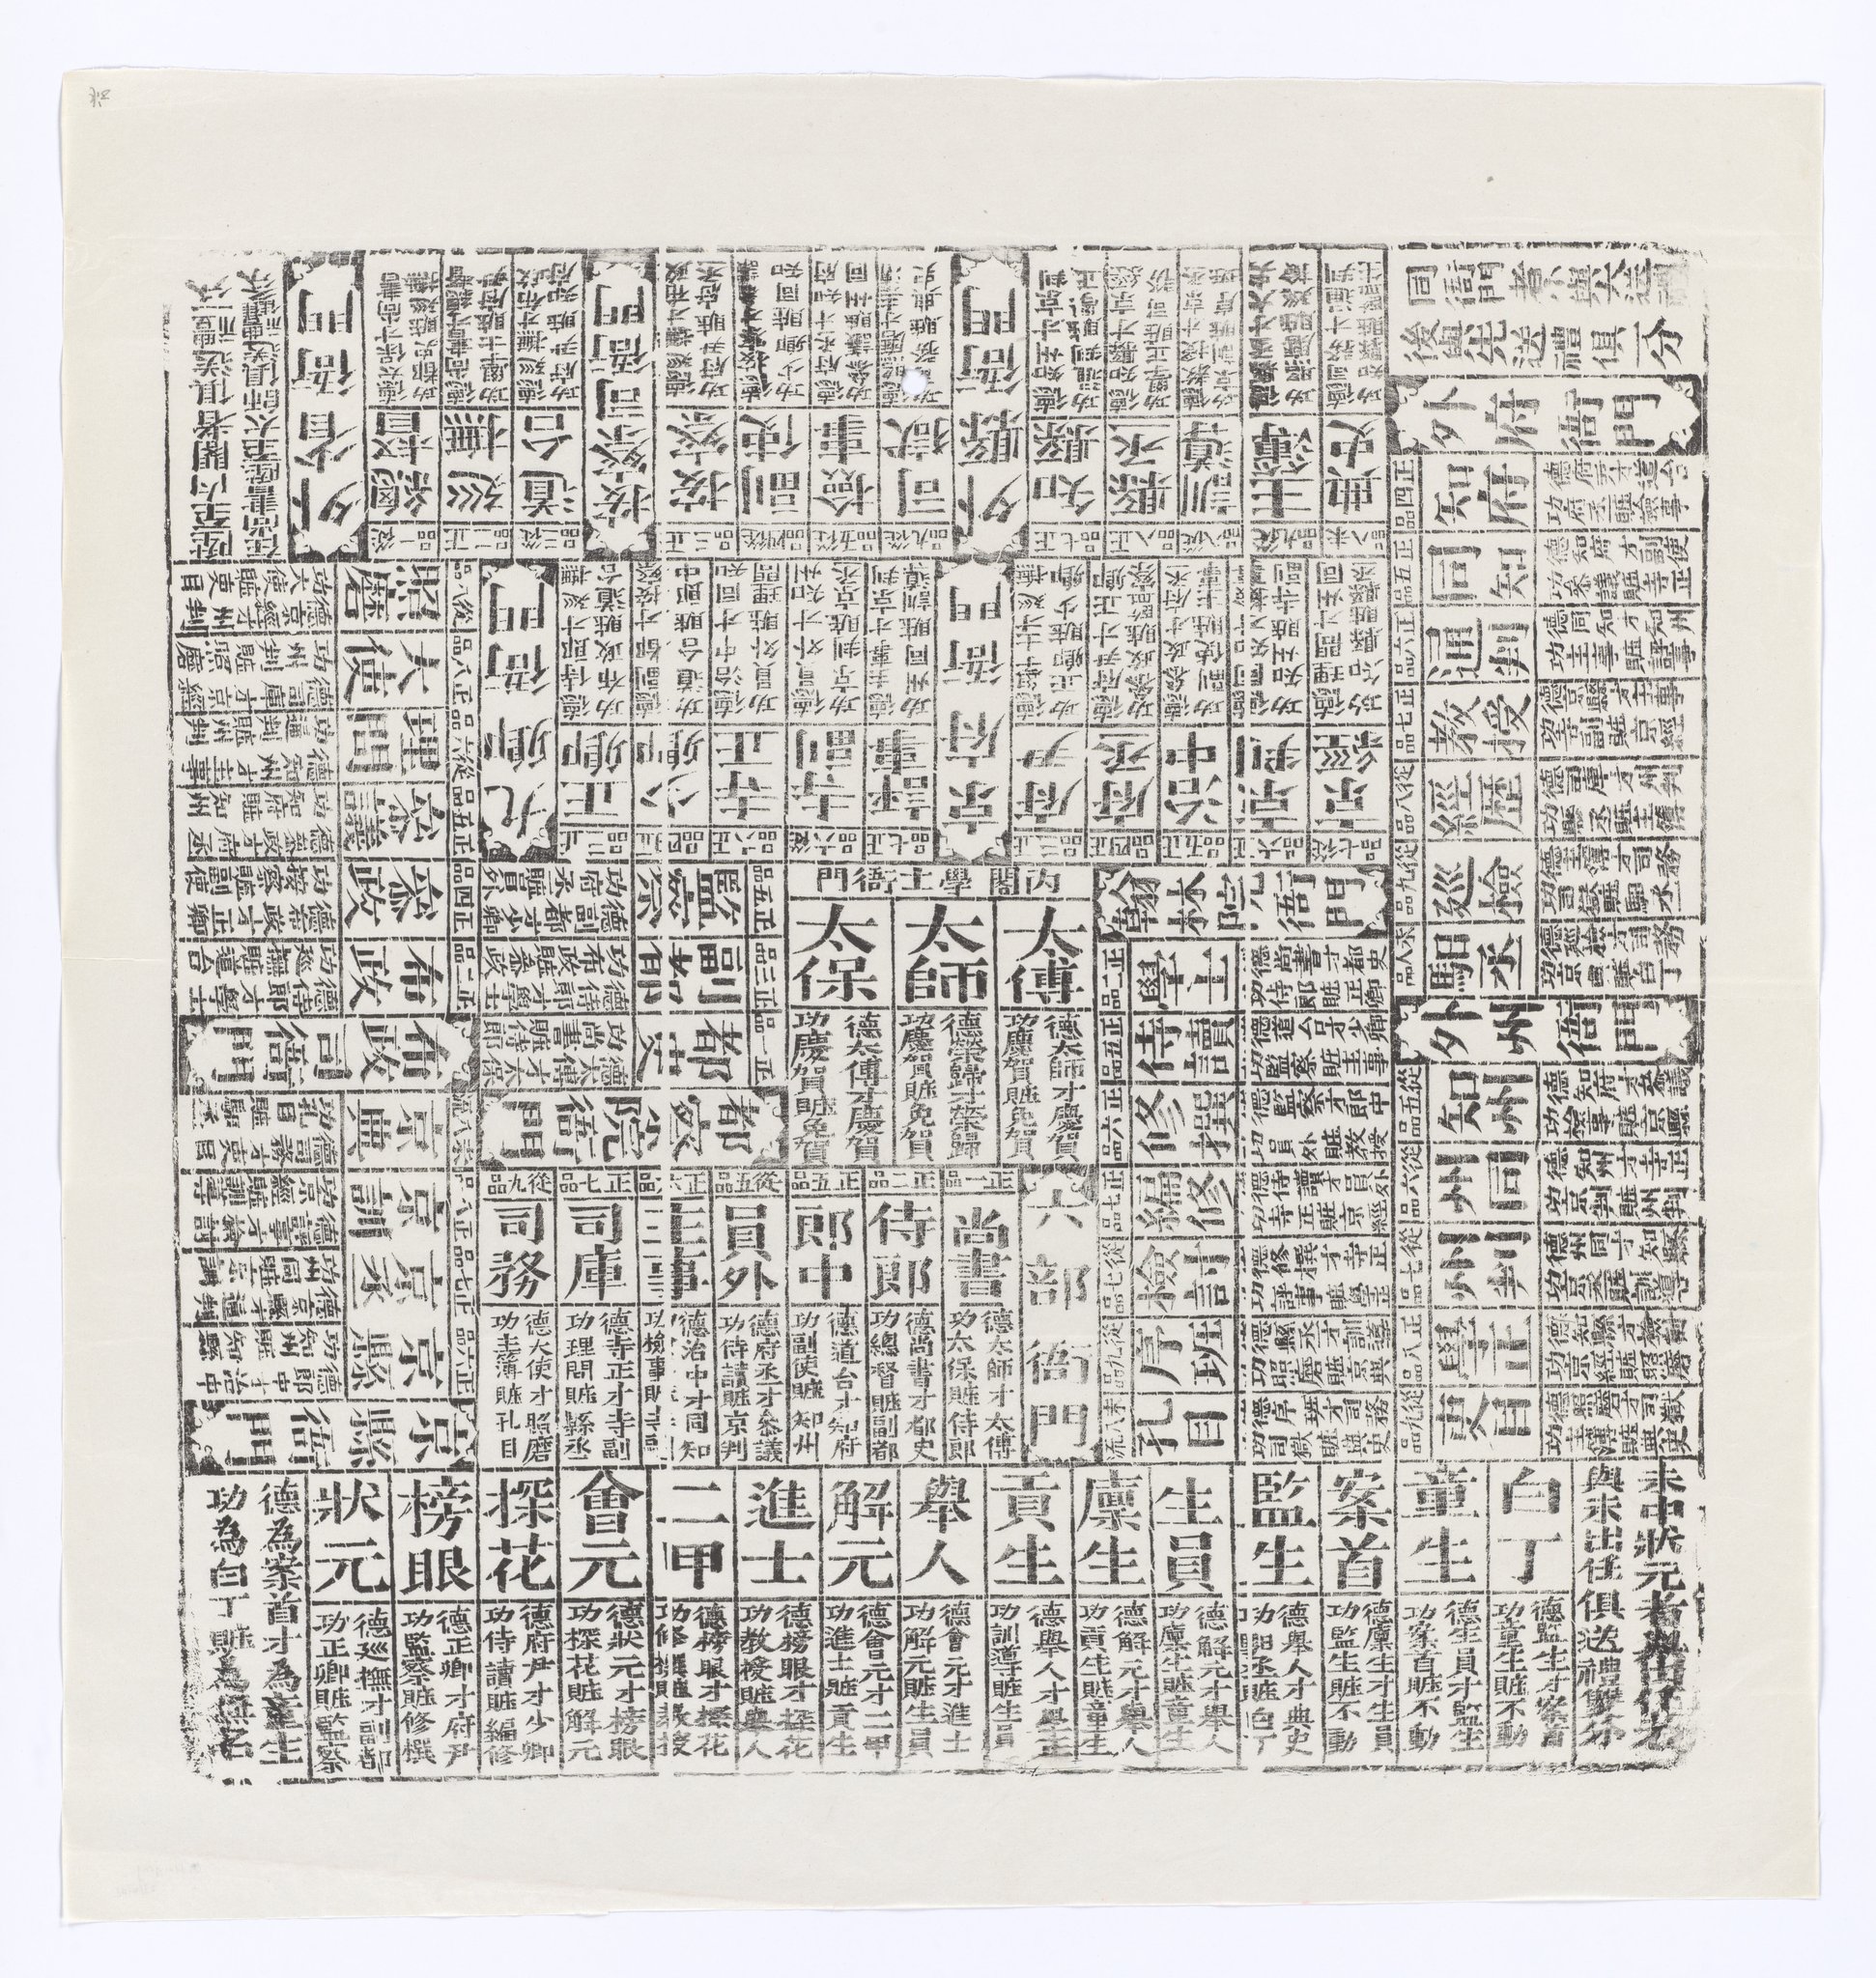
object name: print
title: Promoting Officials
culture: chinese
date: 1701-1800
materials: ink, paper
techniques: woodblock print